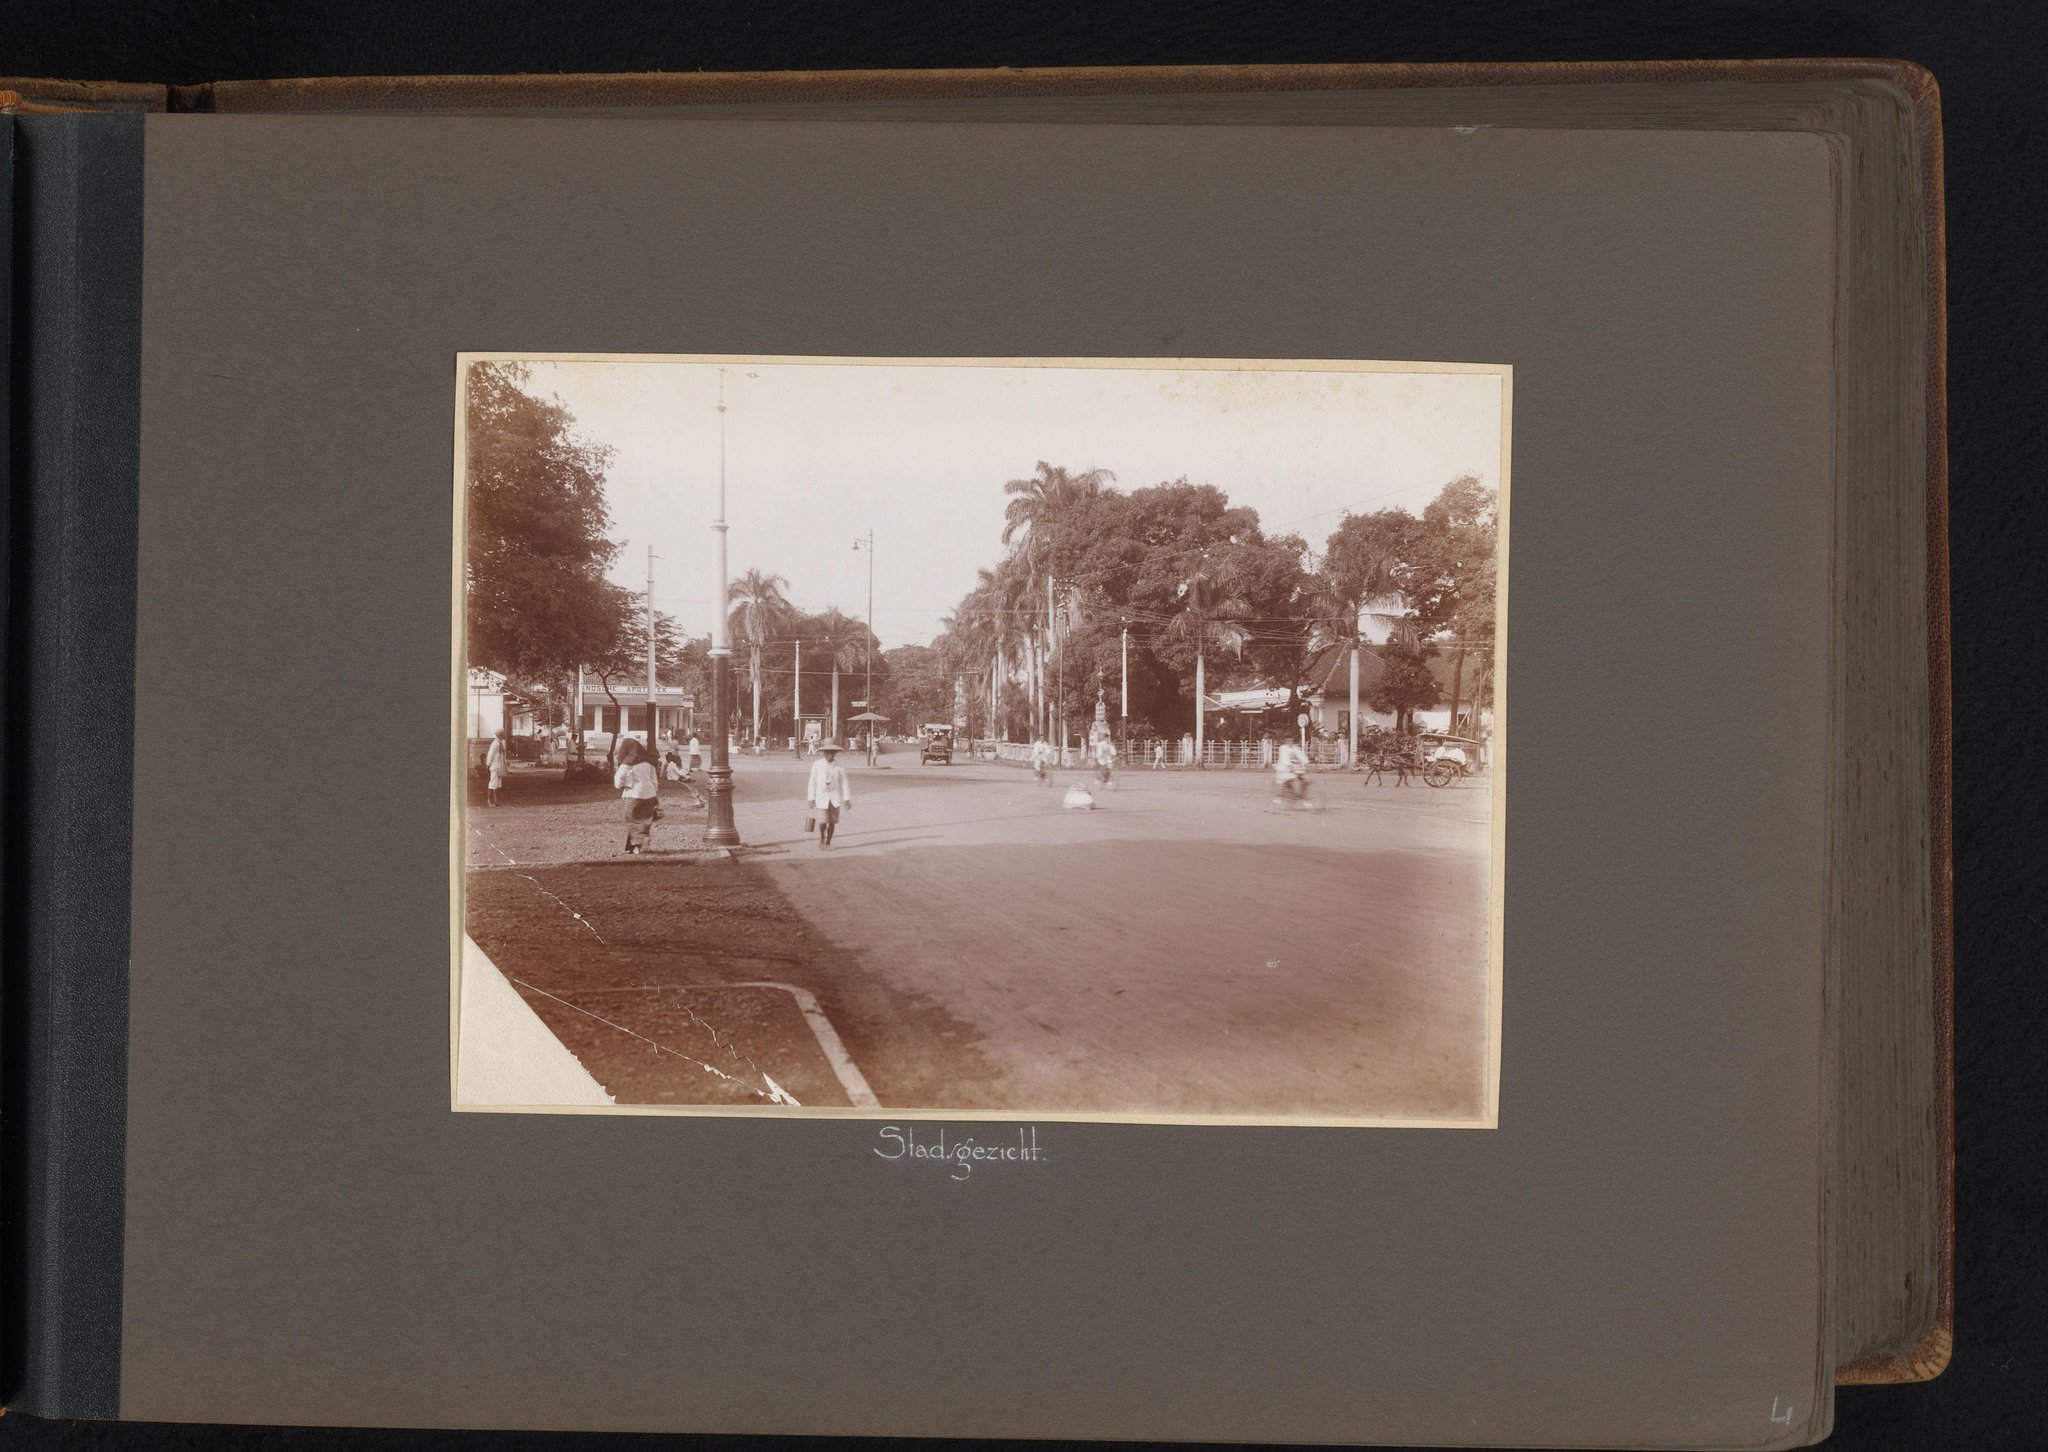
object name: album leaf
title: Stadgezicht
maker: Anonymous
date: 1925-1931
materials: cardboard, photographic support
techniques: collodion silver print, gelatin silver print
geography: batavia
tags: dutch east indies, the, batavia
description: Albumblad met één foto: straatgezicht te Batavia. Onderdeel van het fotoalbum aangeboden aan S. Koster door de Vereeniging van Hoogere Politie Ambtenaren in Nederlandsch-Indië in 1931.